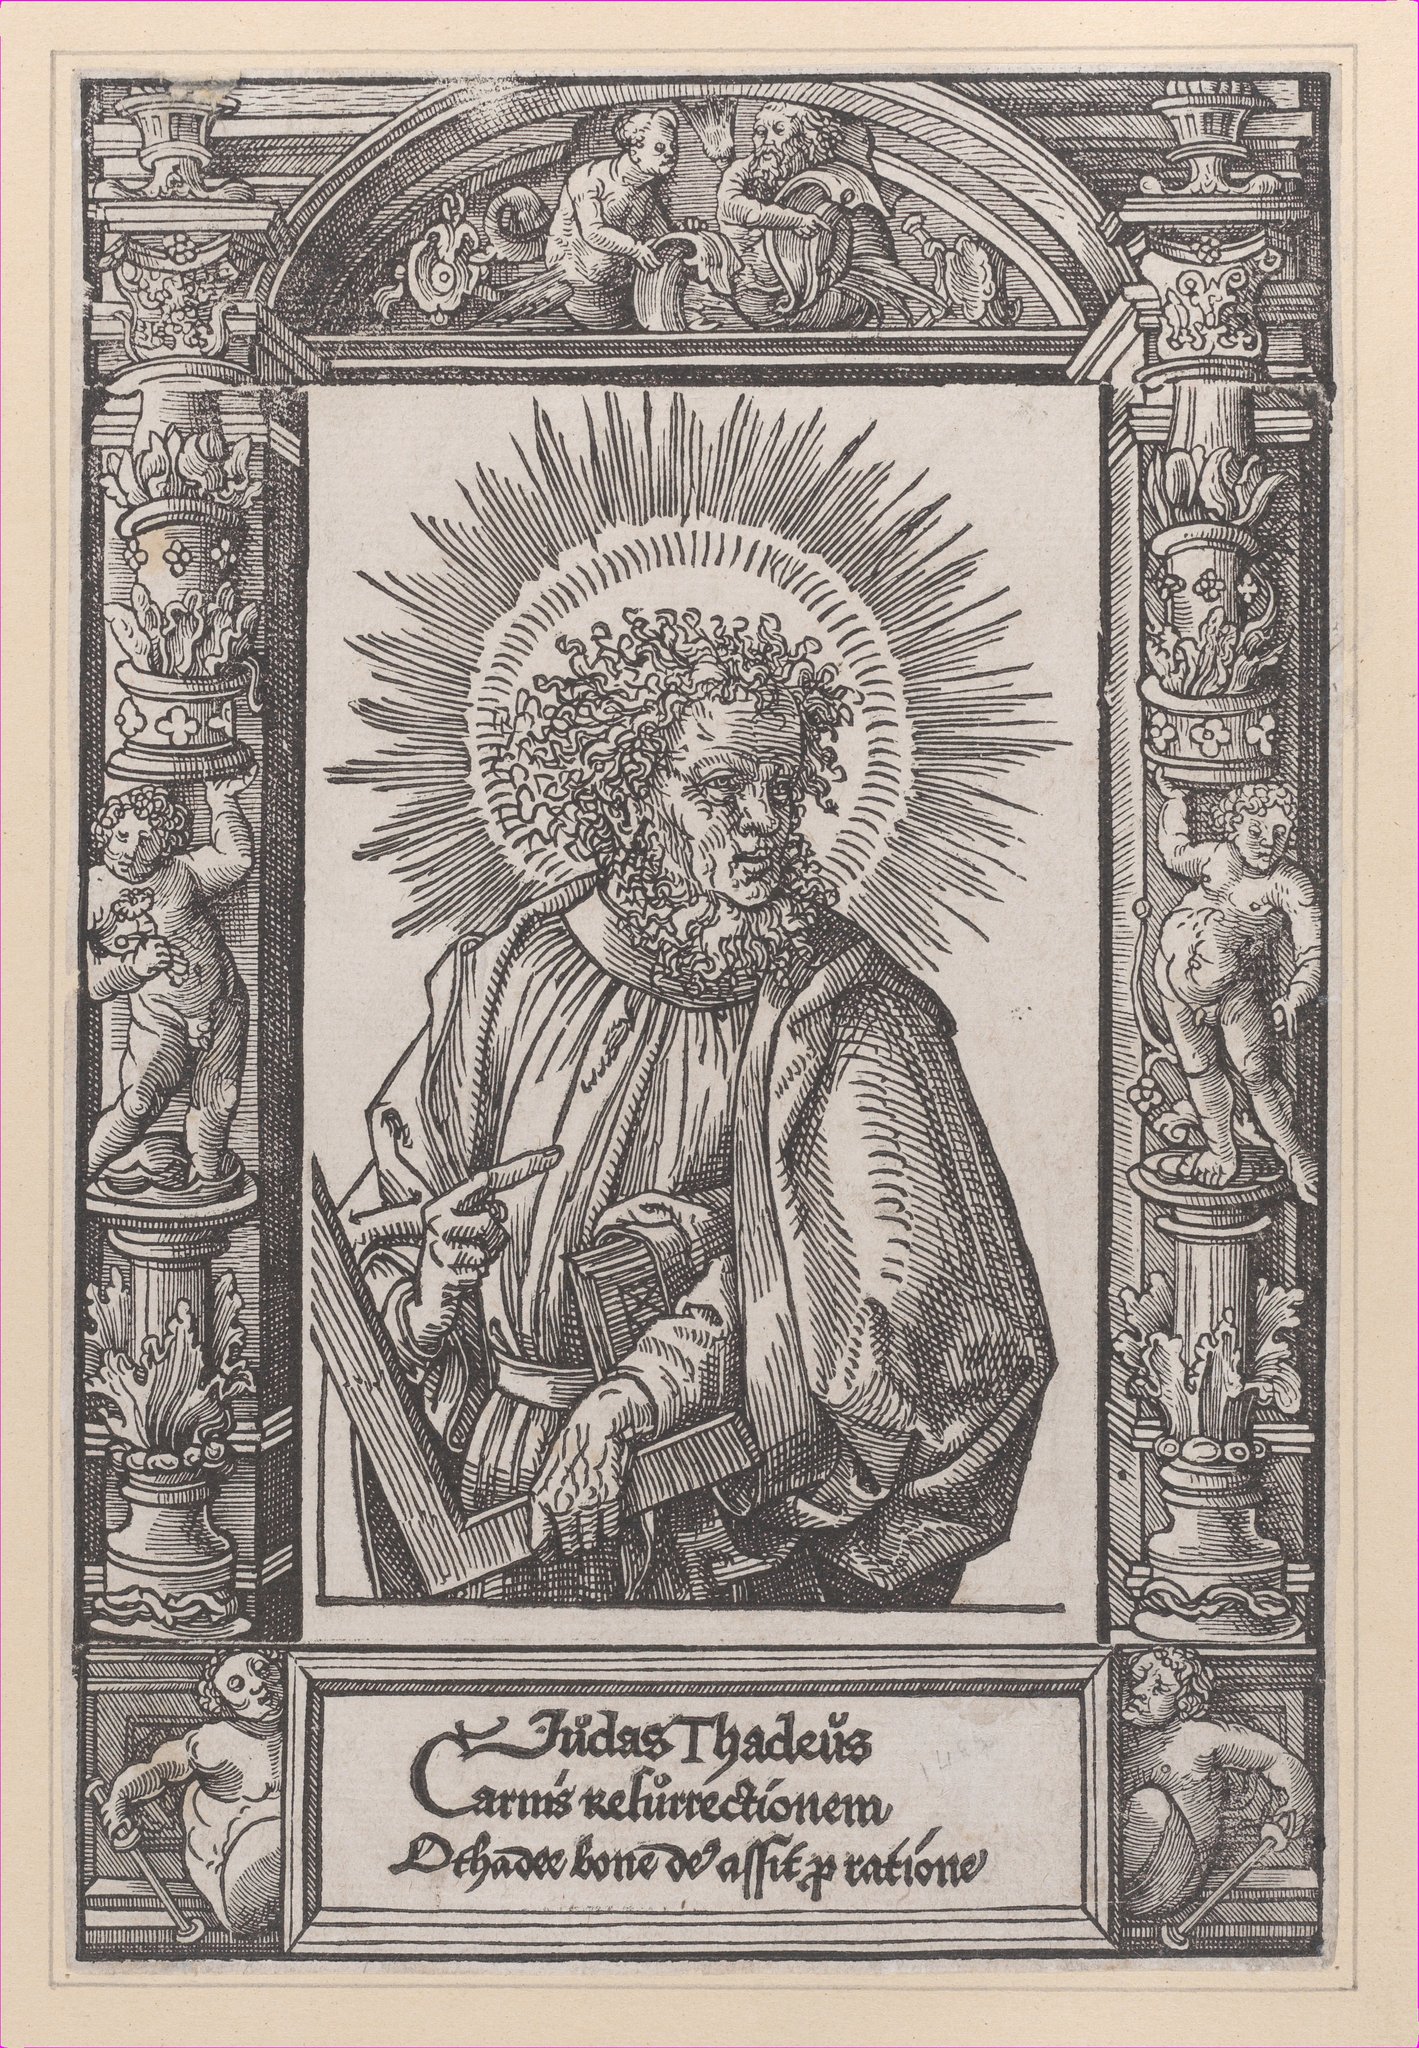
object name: print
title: Judas Thaddaeus, from Christ and the Apostles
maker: jacob cornelisz van oostsanen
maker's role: artist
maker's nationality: netherlandish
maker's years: 1465-1533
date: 1514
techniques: woodcut